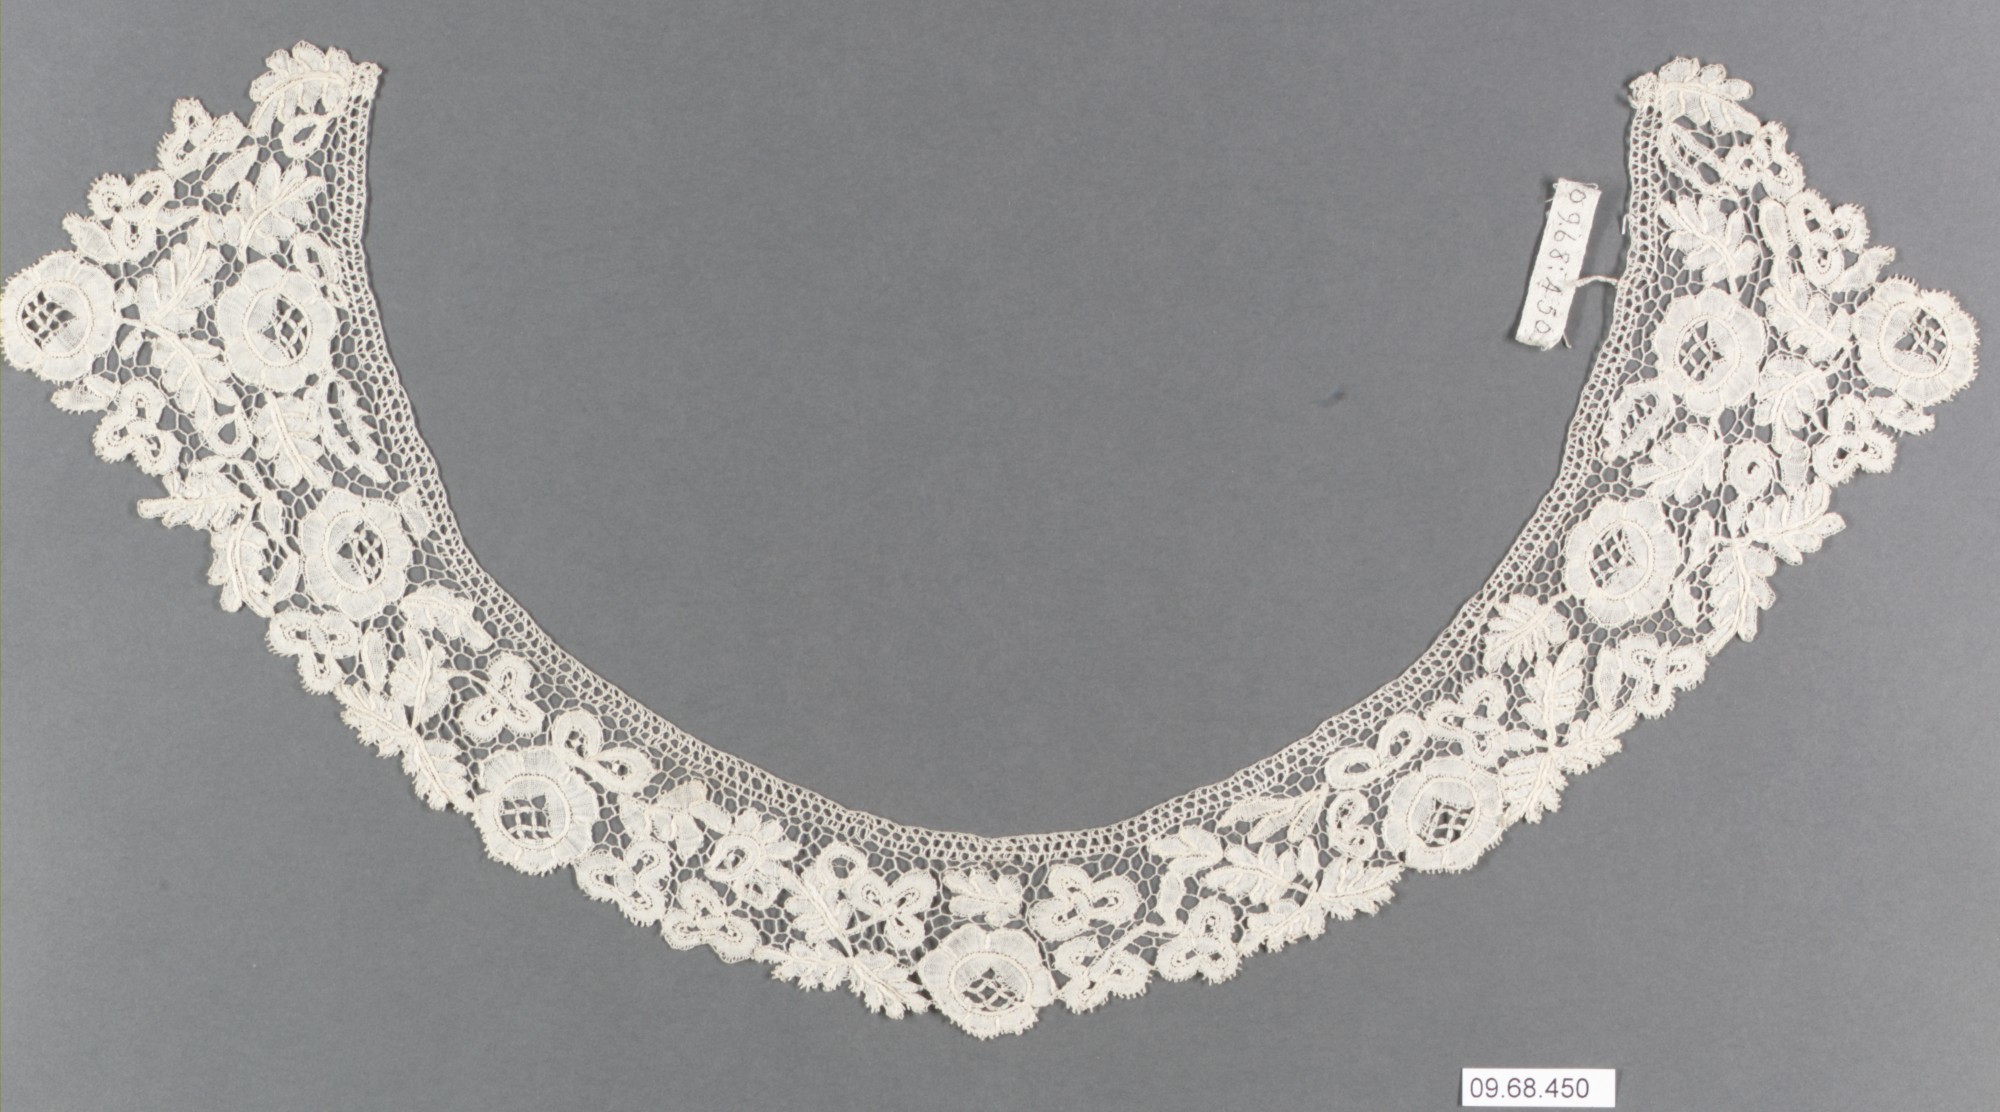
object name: collar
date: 1801-1900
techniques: lace